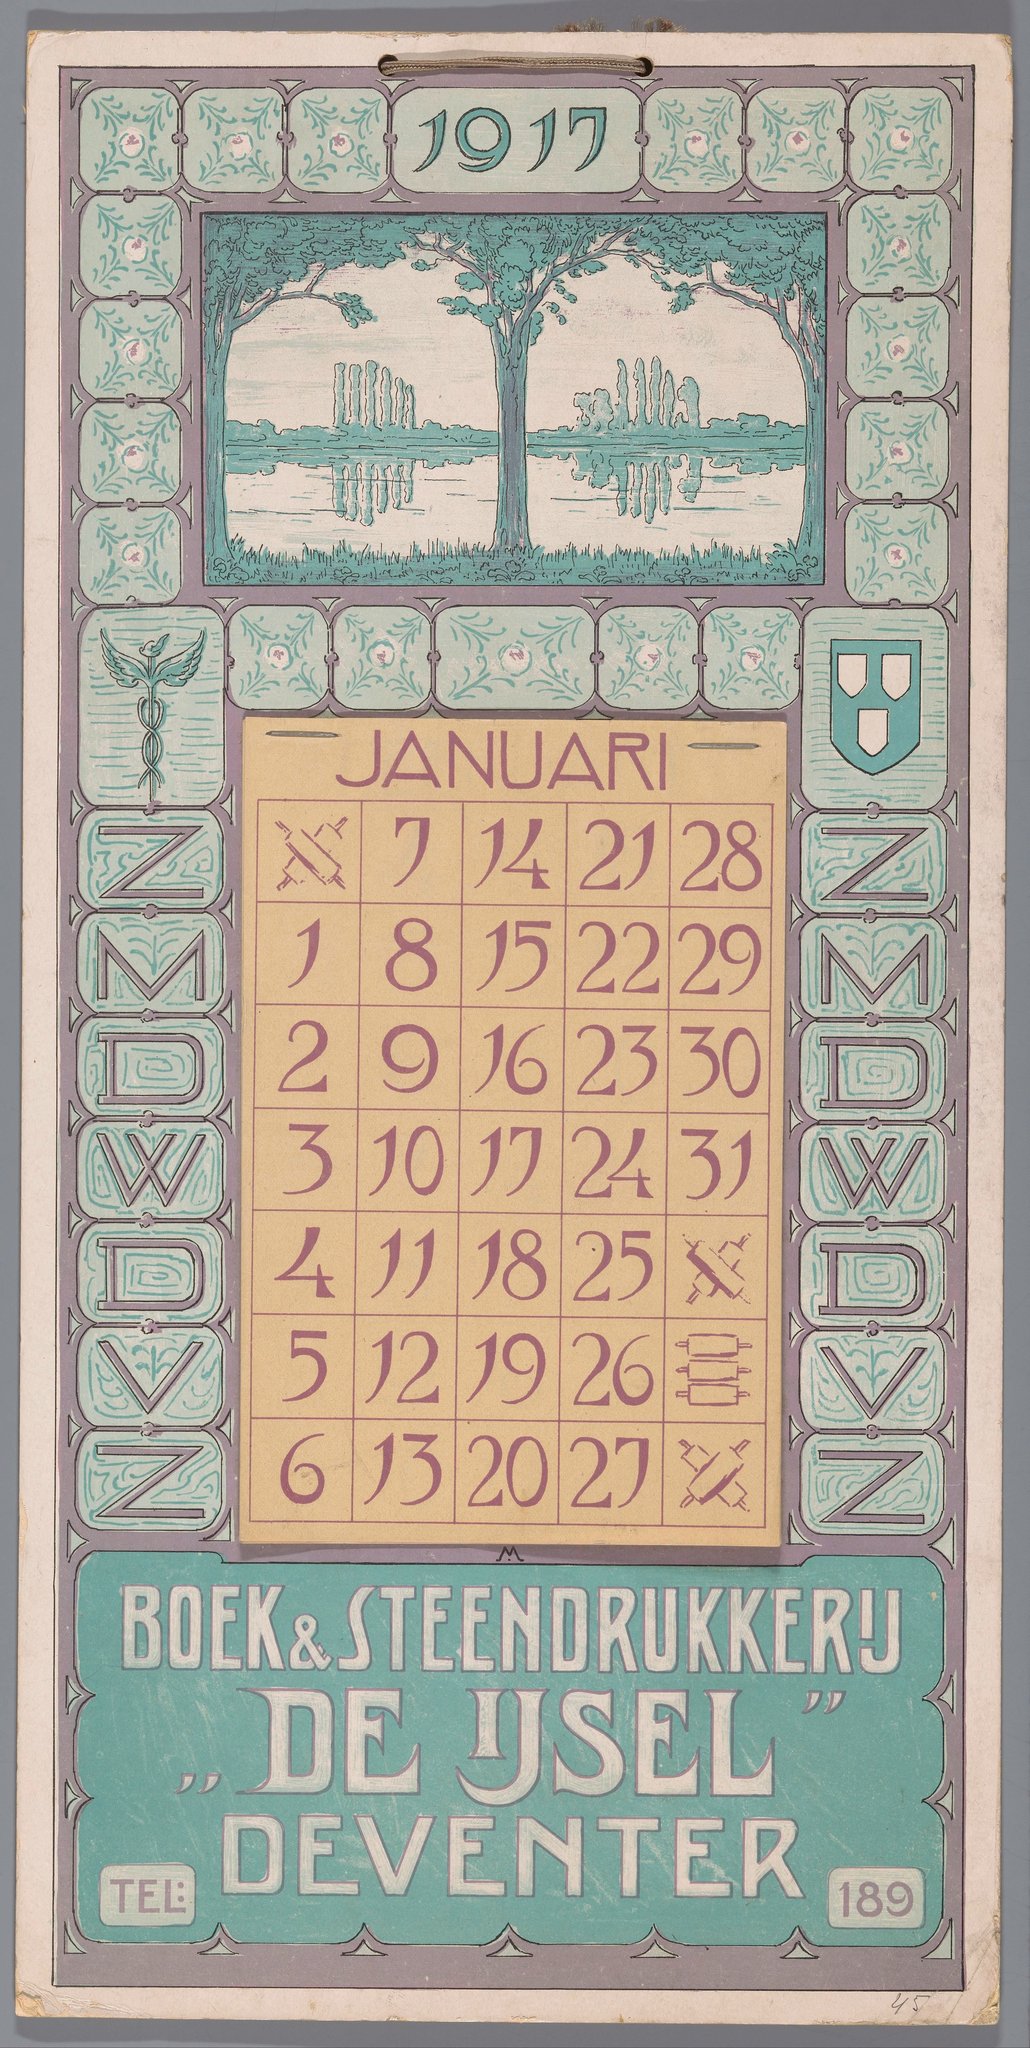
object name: print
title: Kalender 1917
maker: simon moulijn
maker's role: draughtsman, print maker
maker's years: 1866-1948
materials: cardboard, paper, fiber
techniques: lithograph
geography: deventer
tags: calendar, almanac, river, deventer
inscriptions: collector's mark: Lugt 2228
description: Kalender met vooraan het kalenderblad januari 1917 en daaronder de maanden februari tot en met december. Rondom de kalenderbladen een ornamentrand en een rivierlandschap; onderaan de tekst 'Boek & steendrukkerij "De IJsel" Deventer Tel: 189'. Bovenaan twee gaten met een touw om de kalender mee op te hangen.